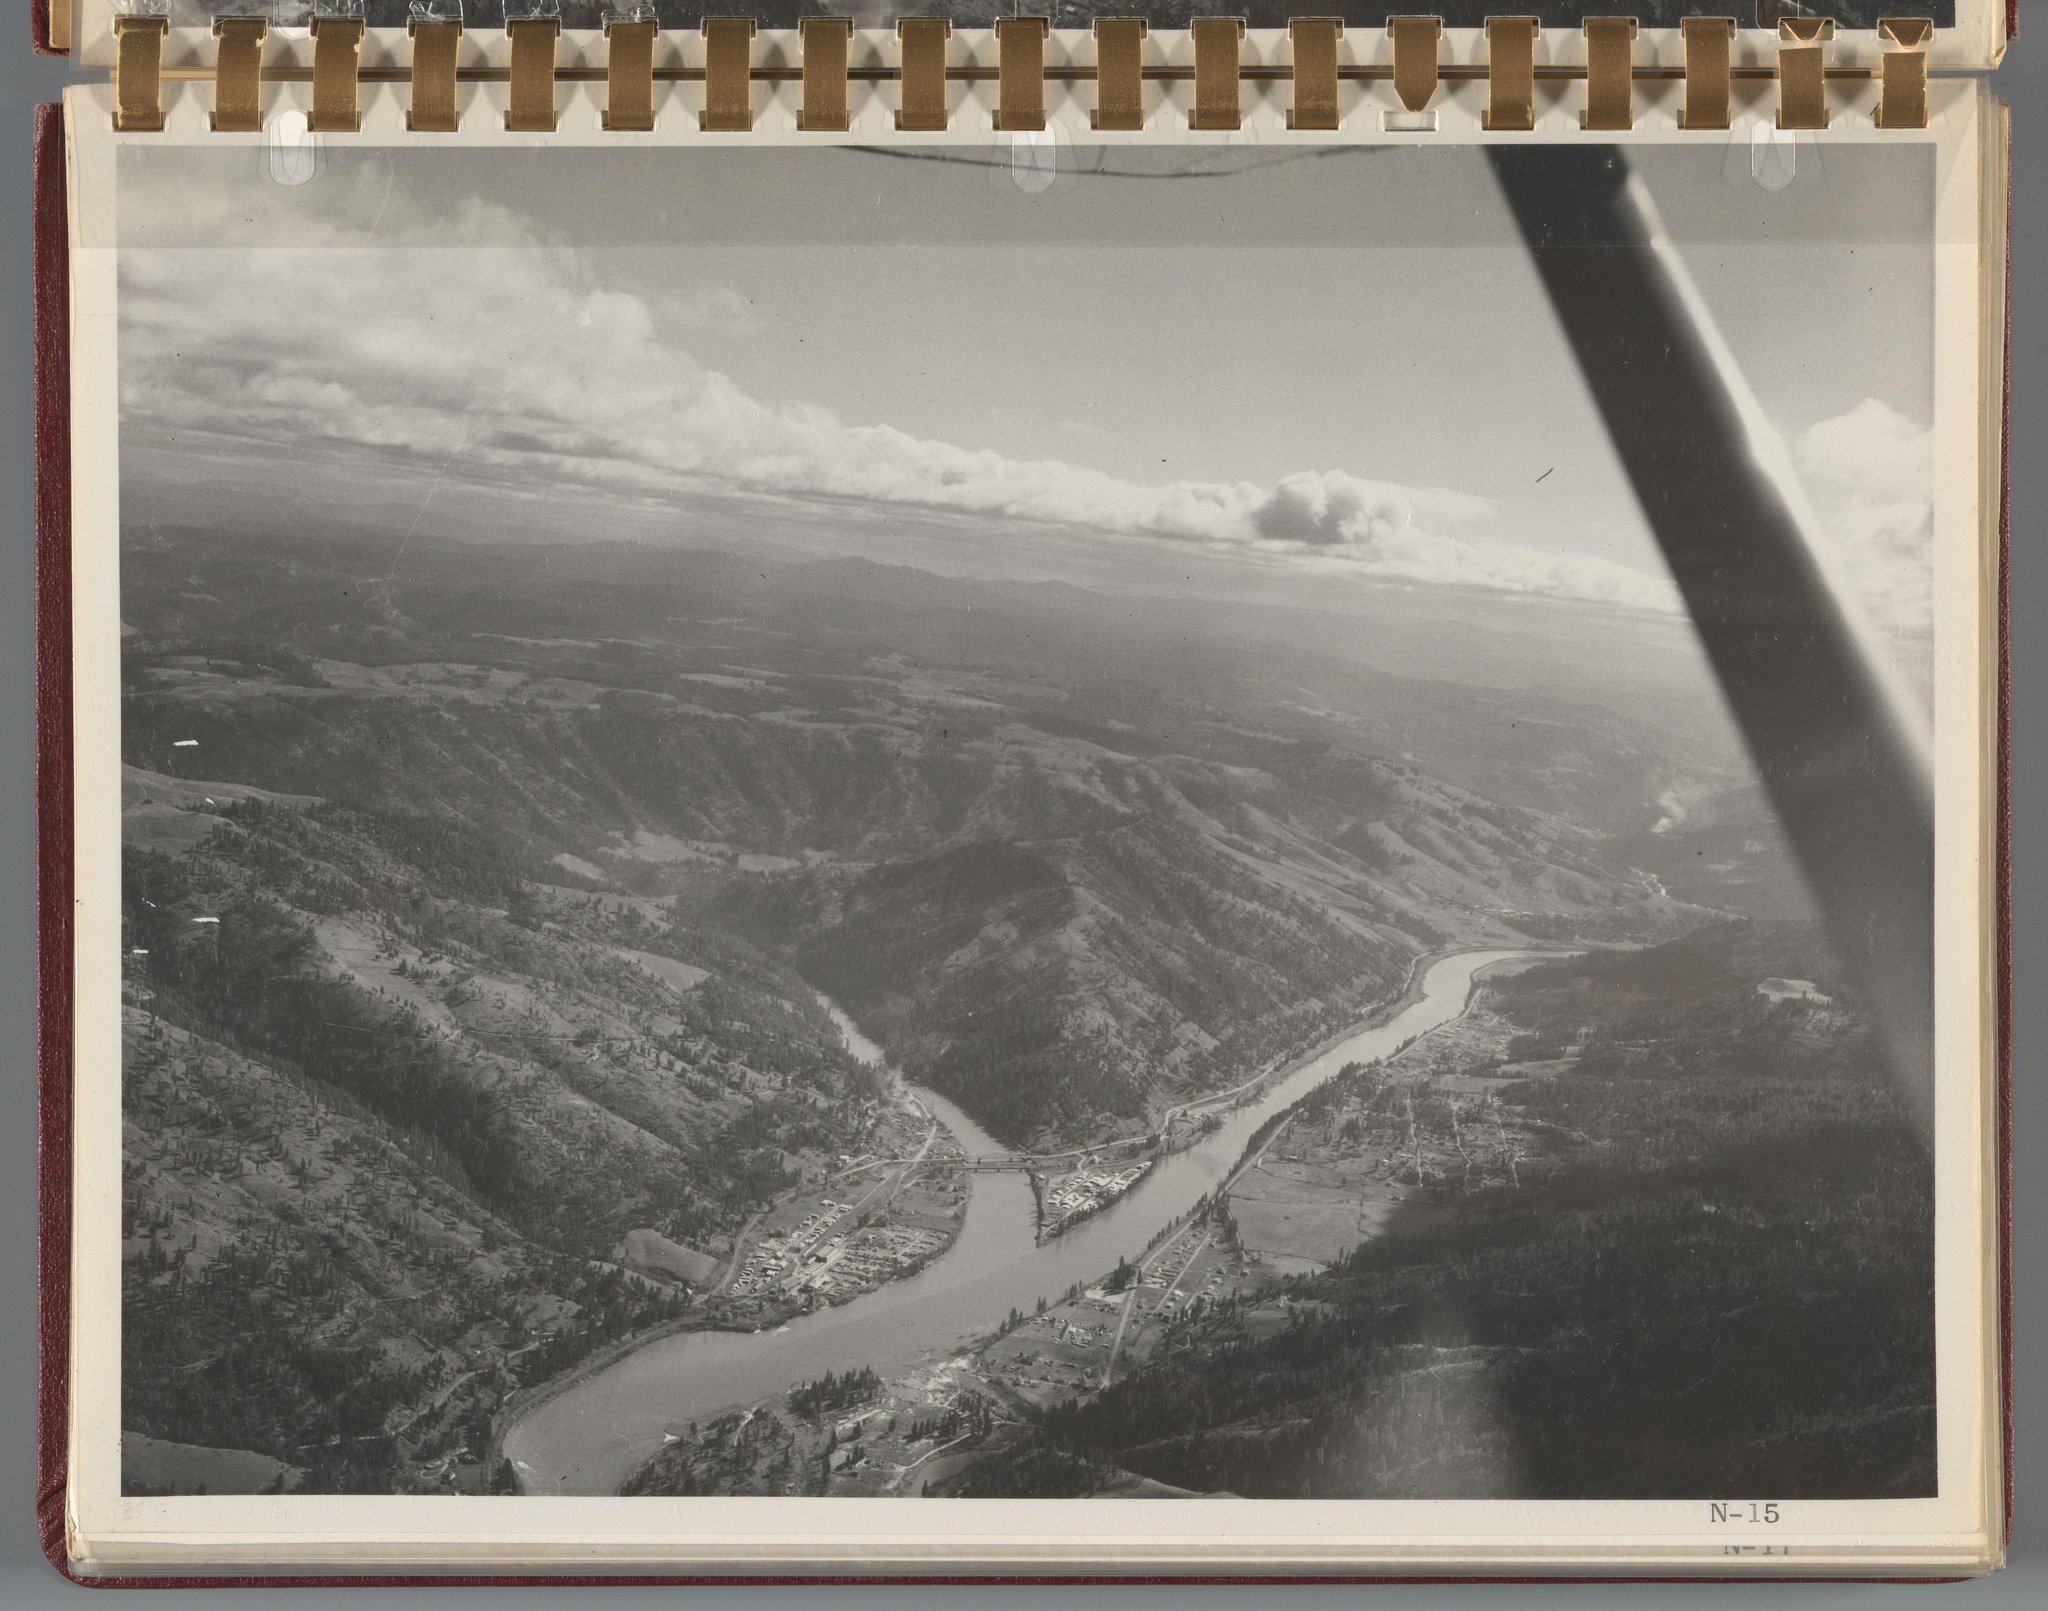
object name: photograph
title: A Worker Sews These By Hand for $1.65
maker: lewis wickes hine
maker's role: fotograaf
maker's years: 1874-1940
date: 1912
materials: photographic support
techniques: gelatin silver print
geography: united states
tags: united states of america